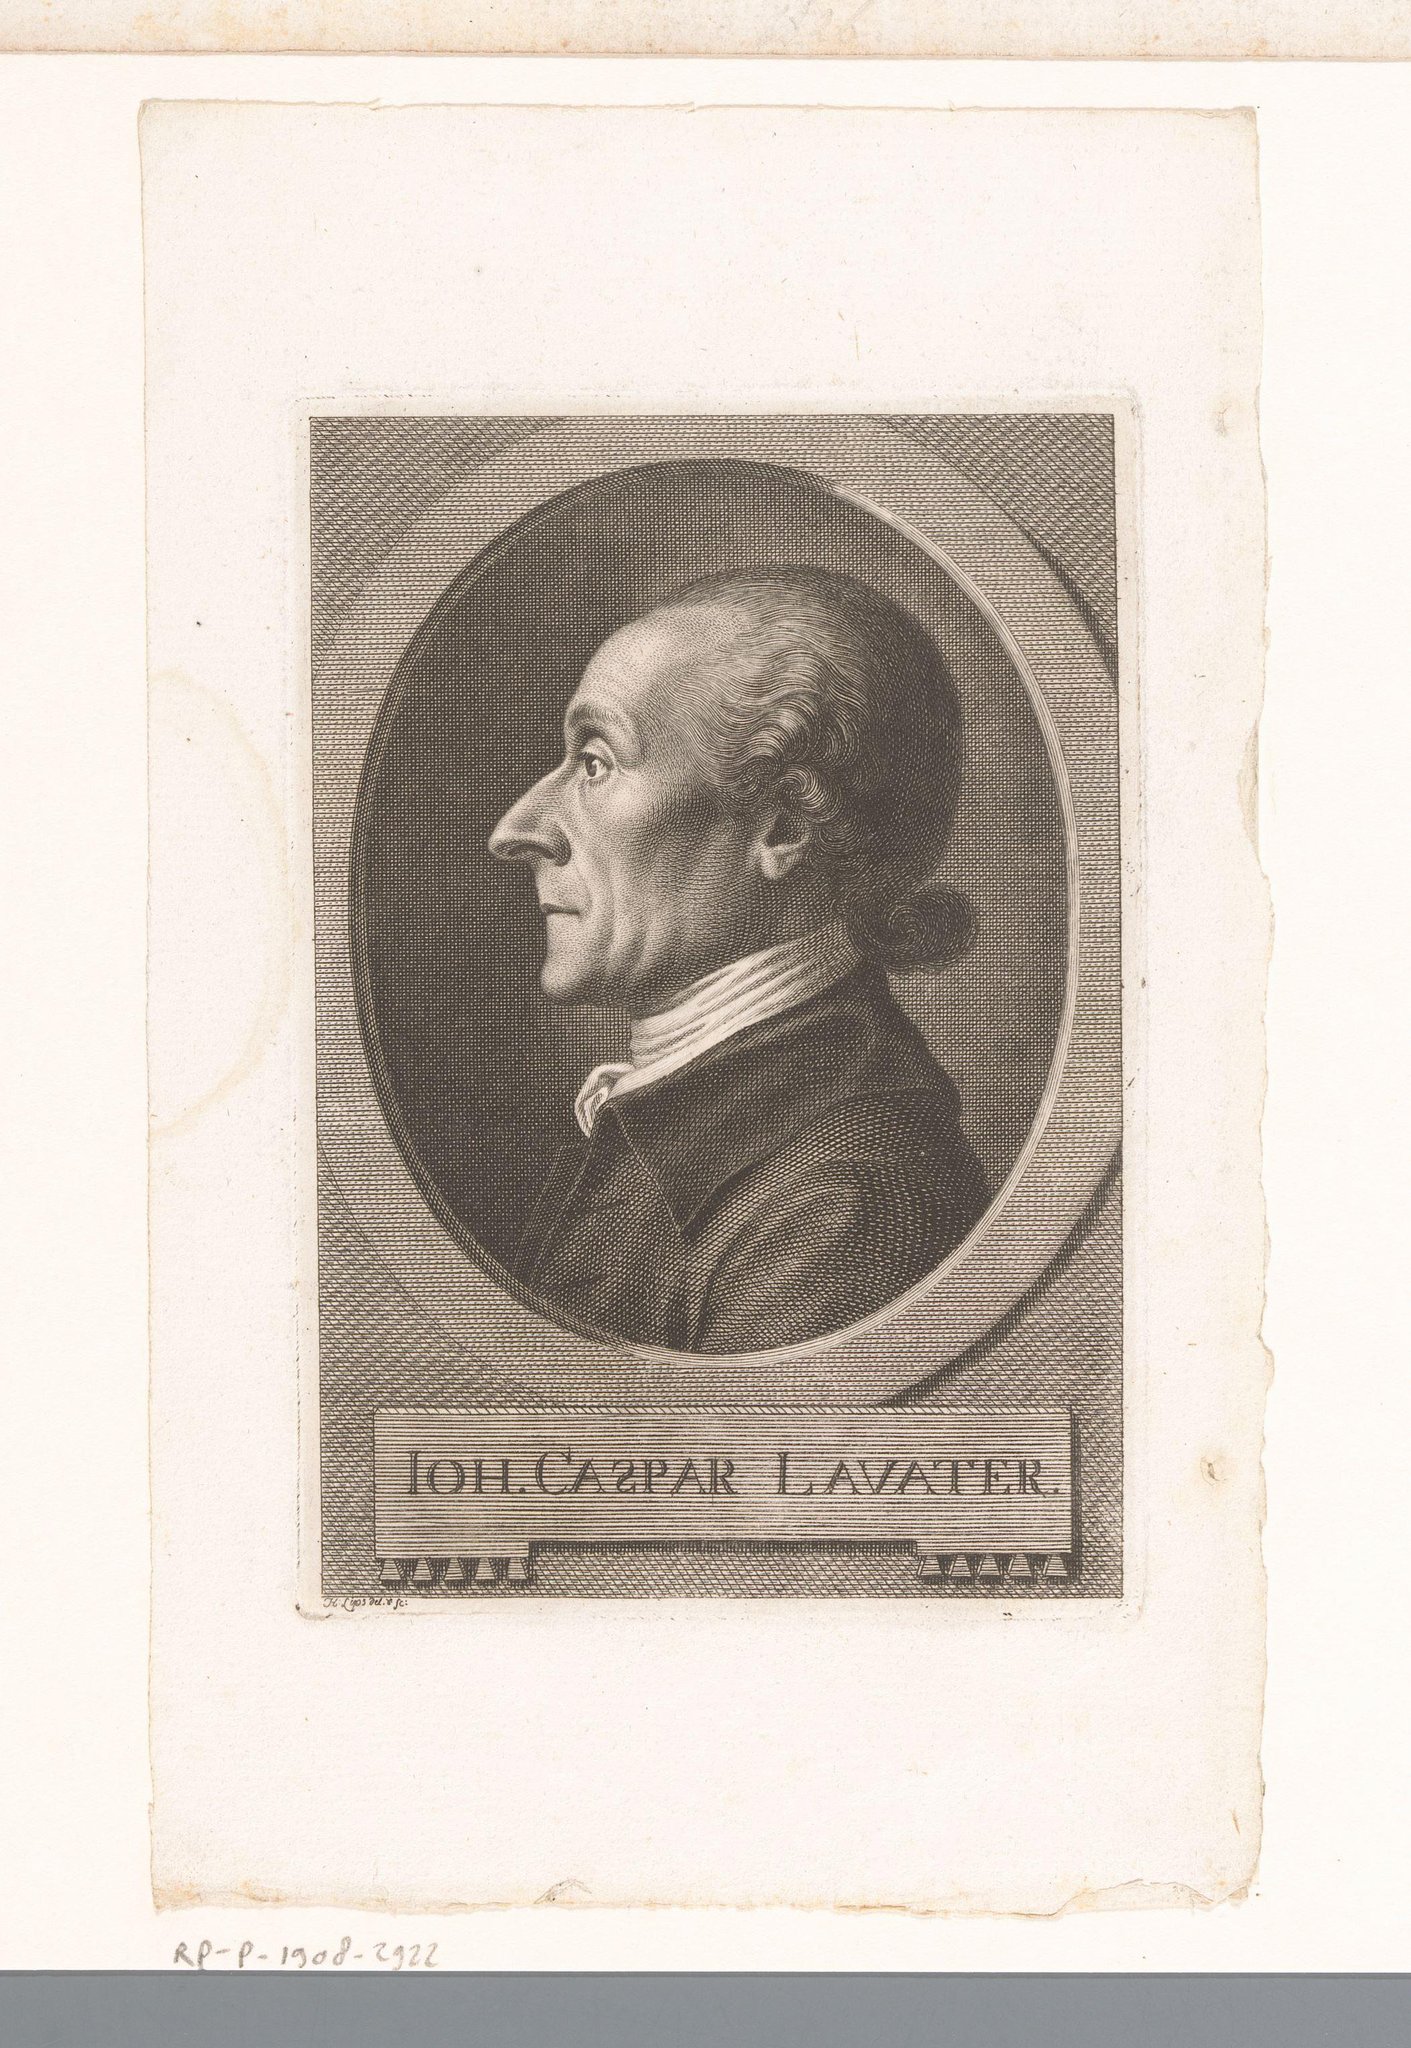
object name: print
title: Portret van Johann Kaspar Lavater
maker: johann heinrich lips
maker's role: draughtsman, painter, print maker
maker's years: 1758-1817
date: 1768-1817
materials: paper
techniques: engraving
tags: johann caspar lavater, historical persons, portrait of a writer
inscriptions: collector's mark: Lugt 2228